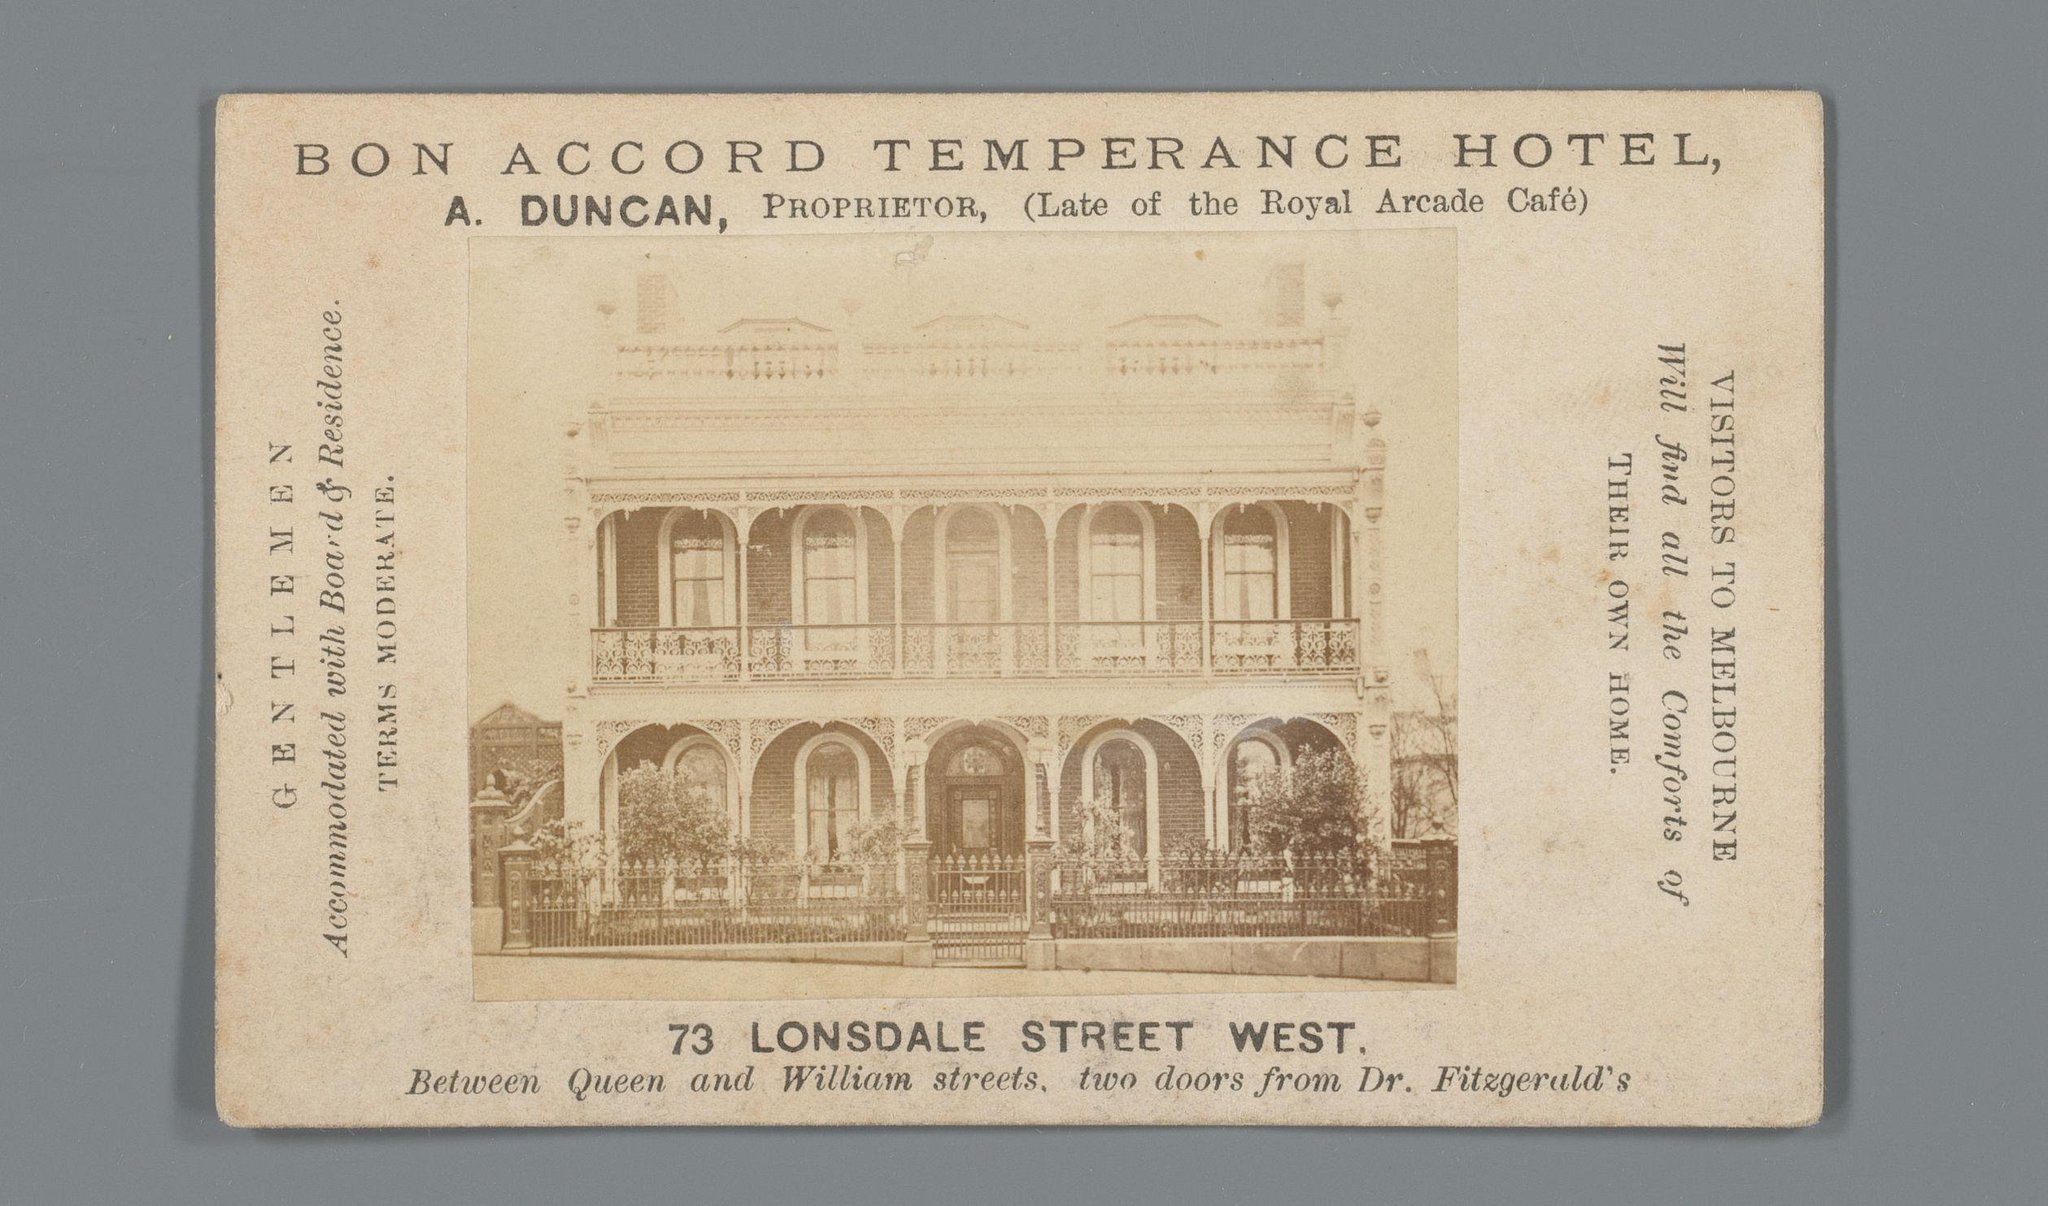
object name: photograph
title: Gezicht op het voormalige Bon Accord Temperance Hotel in Melbourne, Australië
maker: Anonymous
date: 1850-1915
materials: cardboard, photographic support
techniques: albumen print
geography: melbourne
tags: advertising, hotel, hostelry, inn